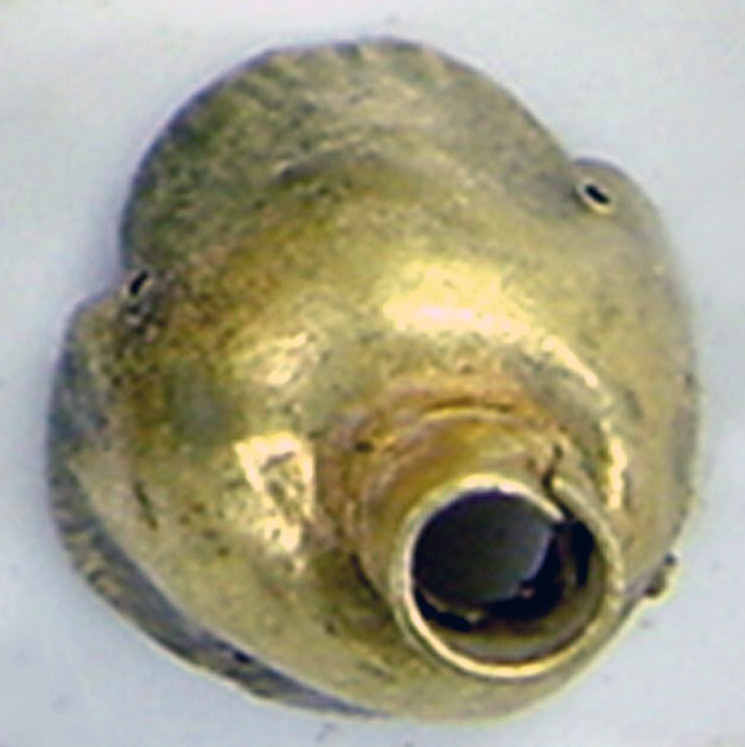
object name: plaque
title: Flower-Shaped Plaque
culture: northwest chinese or eastern central asian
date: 634-900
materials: gold